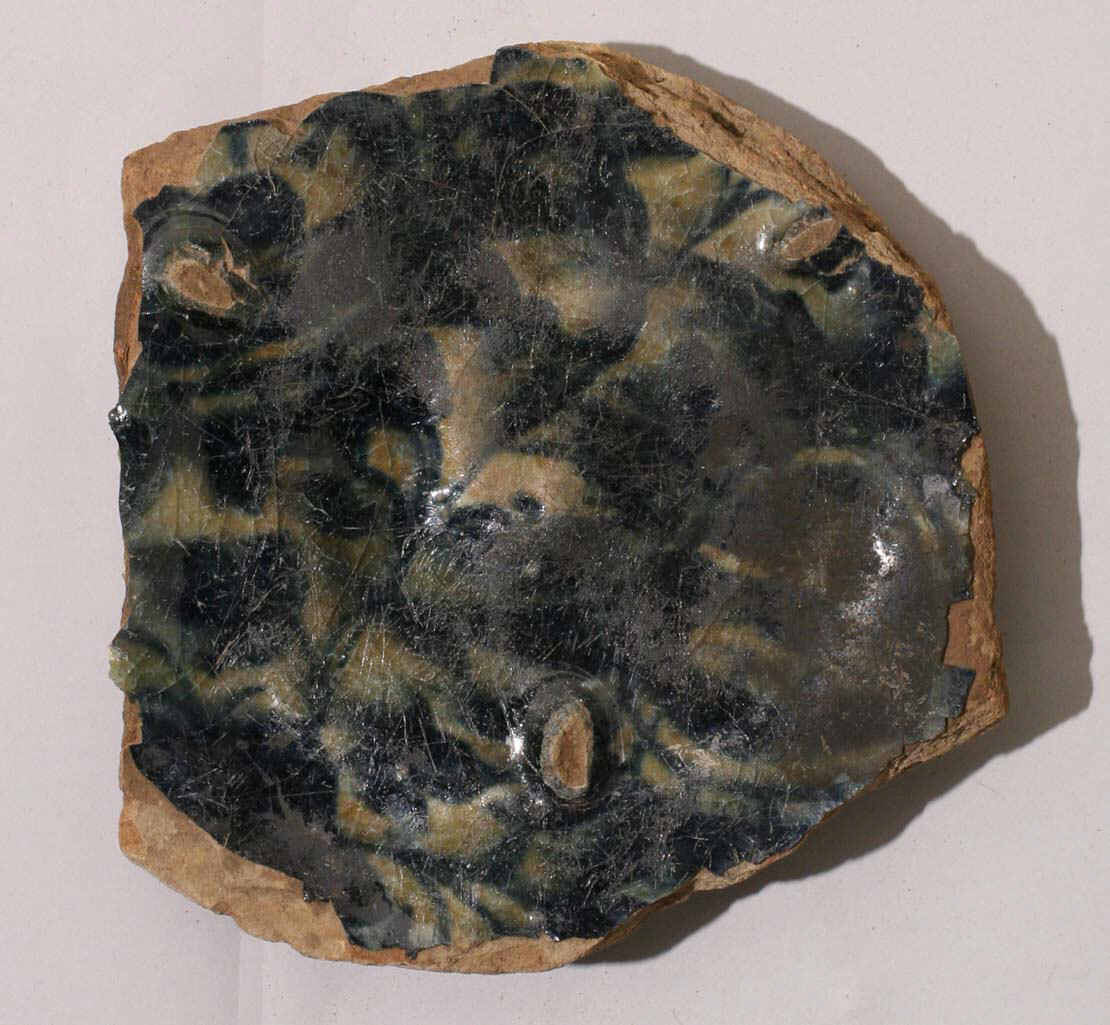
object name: fragment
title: Fragment of a Bowl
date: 1401-1500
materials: glaze, stonepaste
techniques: painting, underglaze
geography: egypt